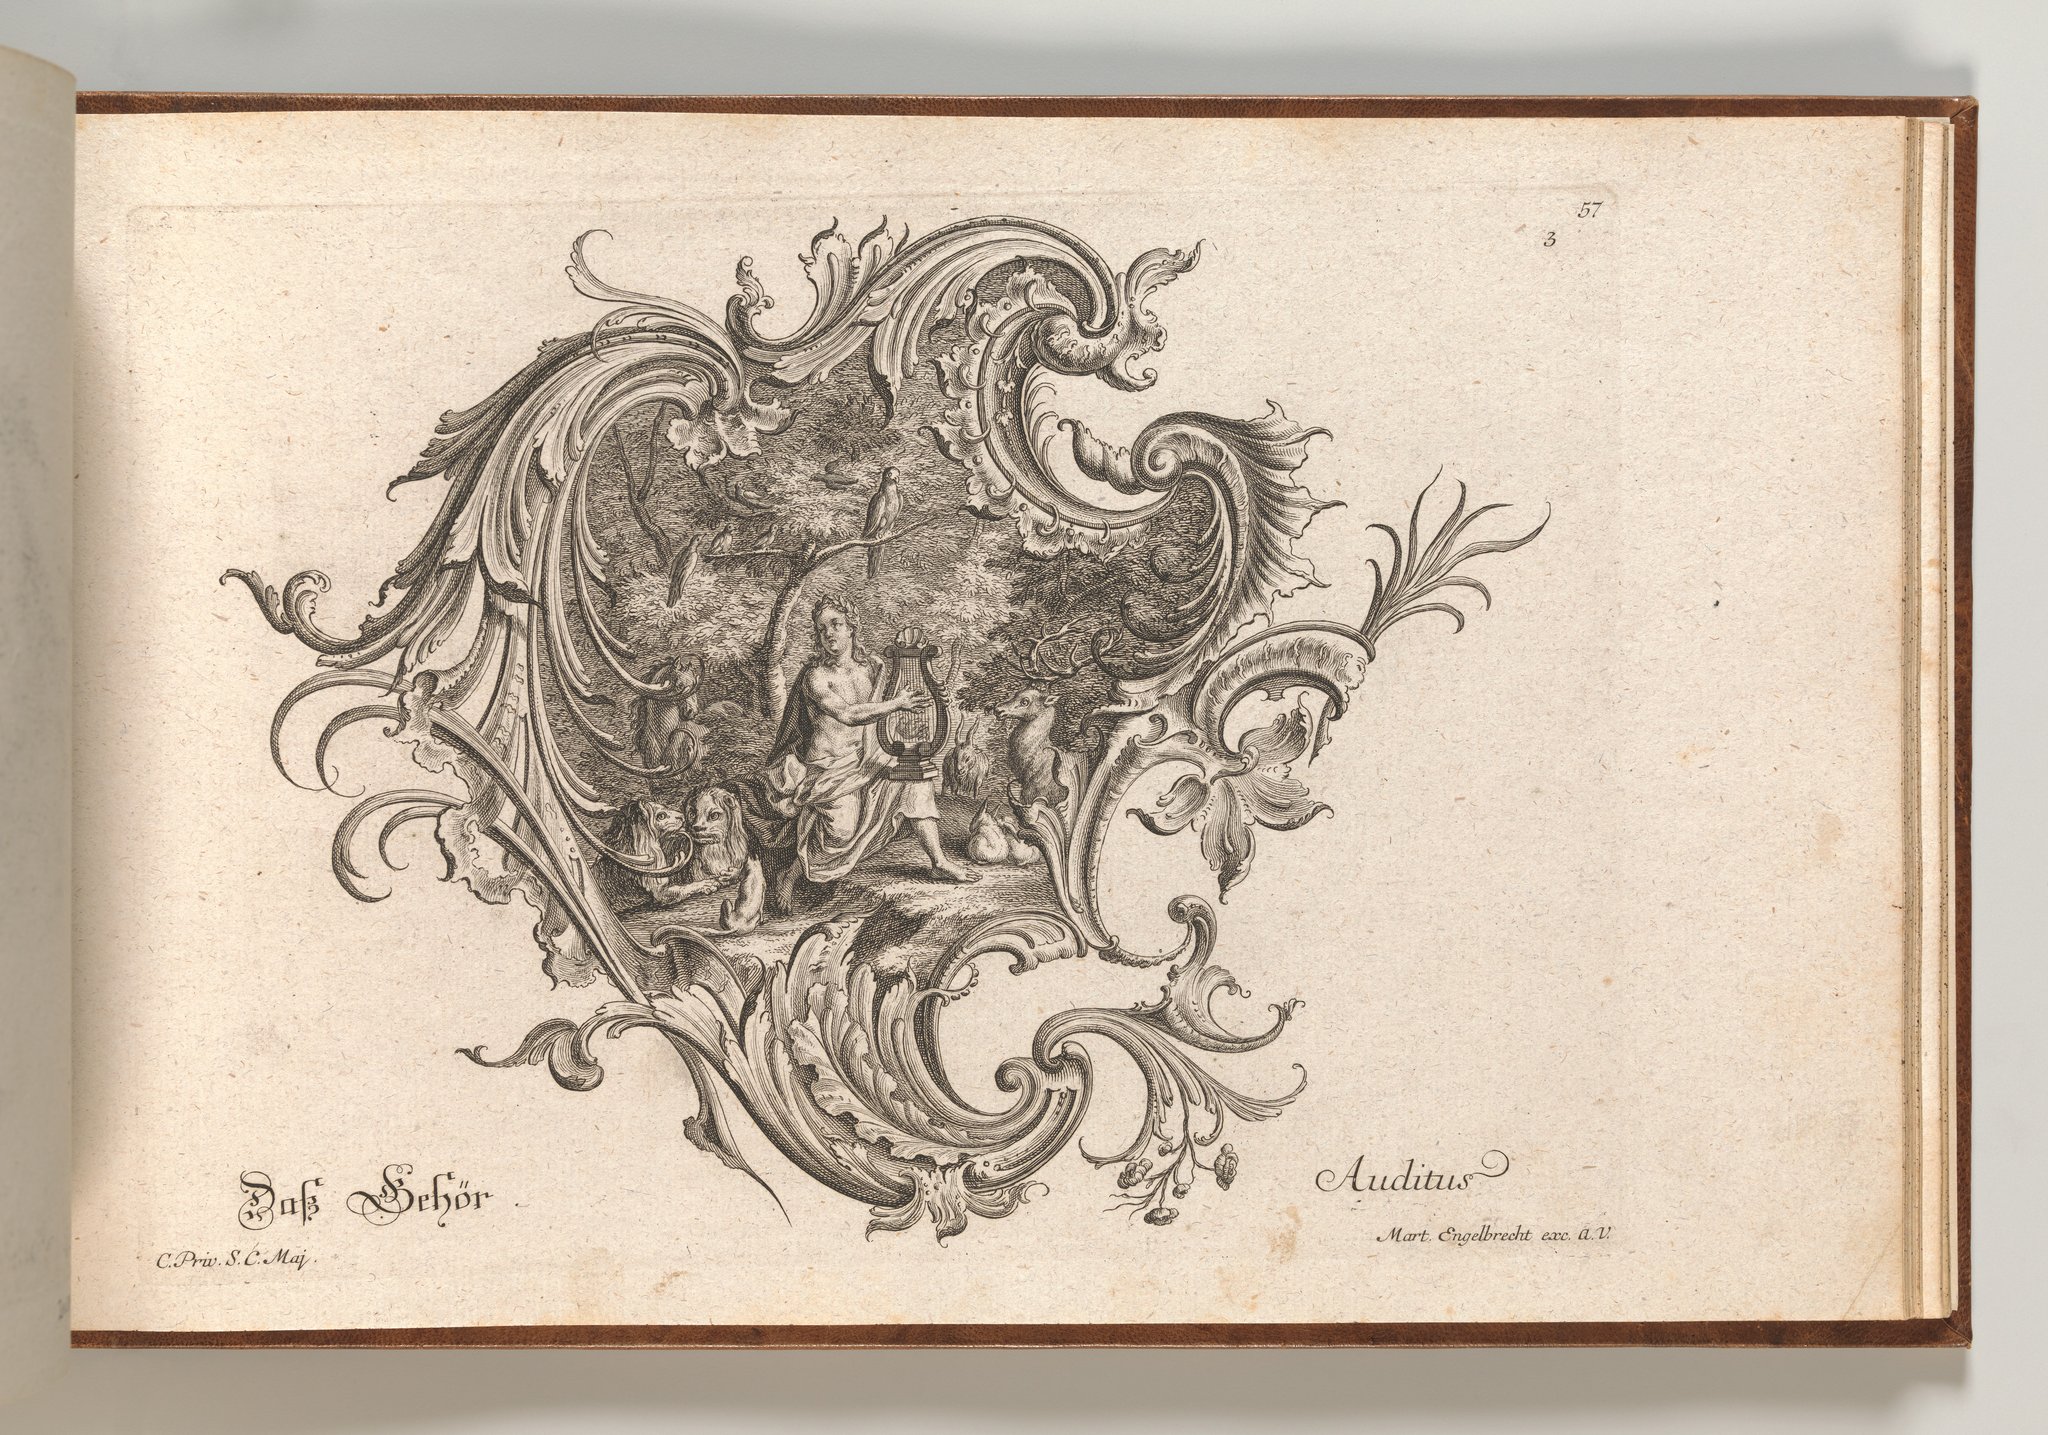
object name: album print ornament architecture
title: Design for a Cartouche and Representation of 'Hearing', Plate 3 from 'Neu Inventierte auf die artigste Facon Sehr nutzliche Schild.'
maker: johann georg pintz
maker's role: engraver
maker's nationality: central european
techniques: etching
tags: animals,birds,cartouches,orpheus